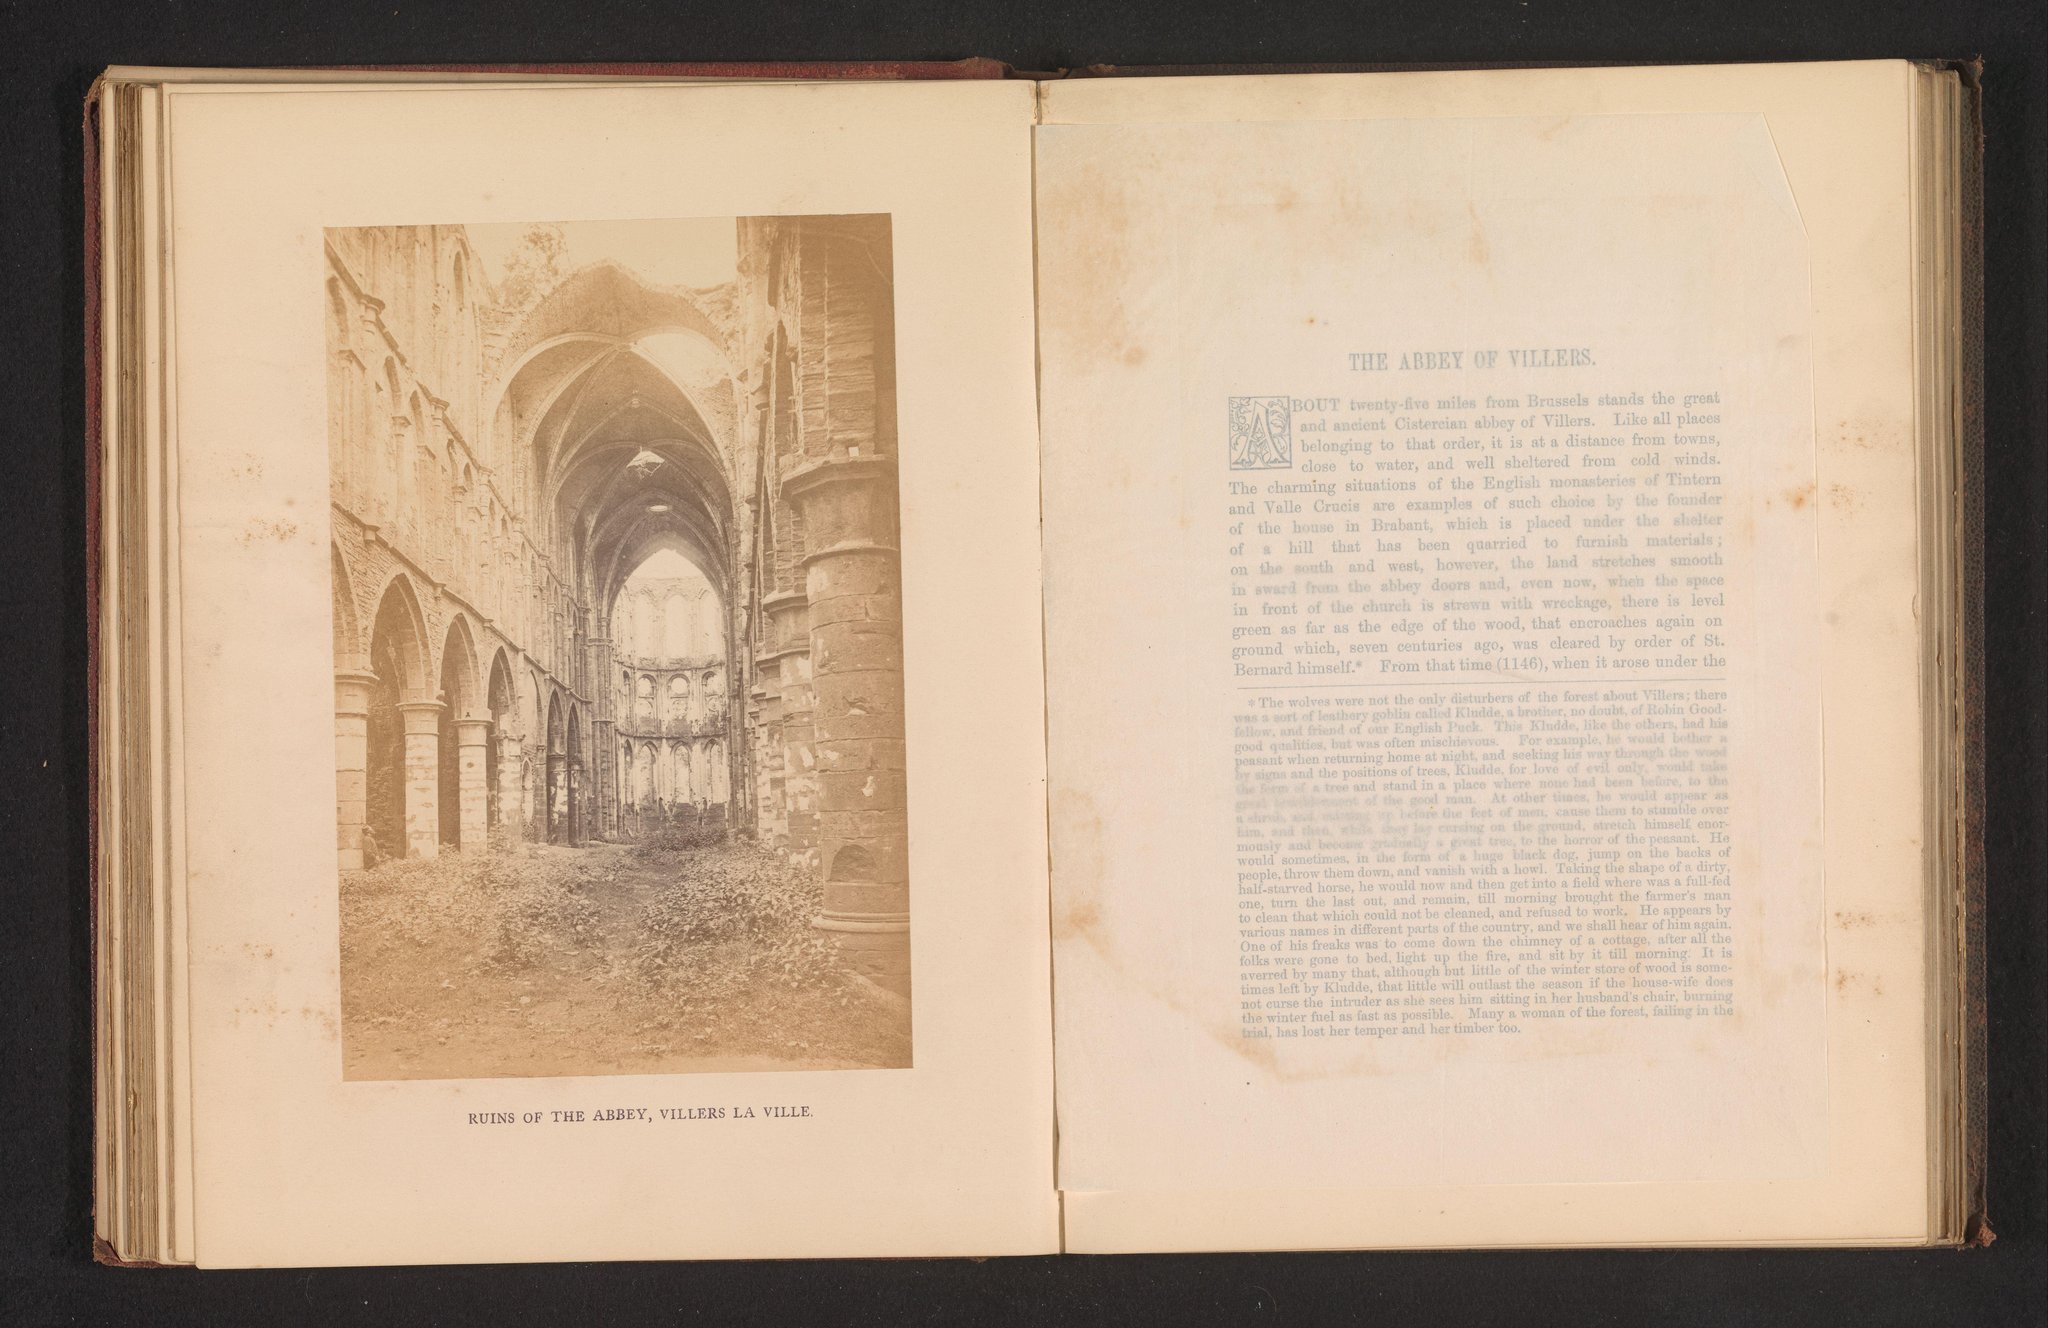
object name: page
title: Ruins of the abbey, Villers la ville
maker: Anonymous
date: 1856-1866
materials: photographic support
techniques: albumen print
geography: villers-la-ville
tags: ruin of church, monastery, etc.